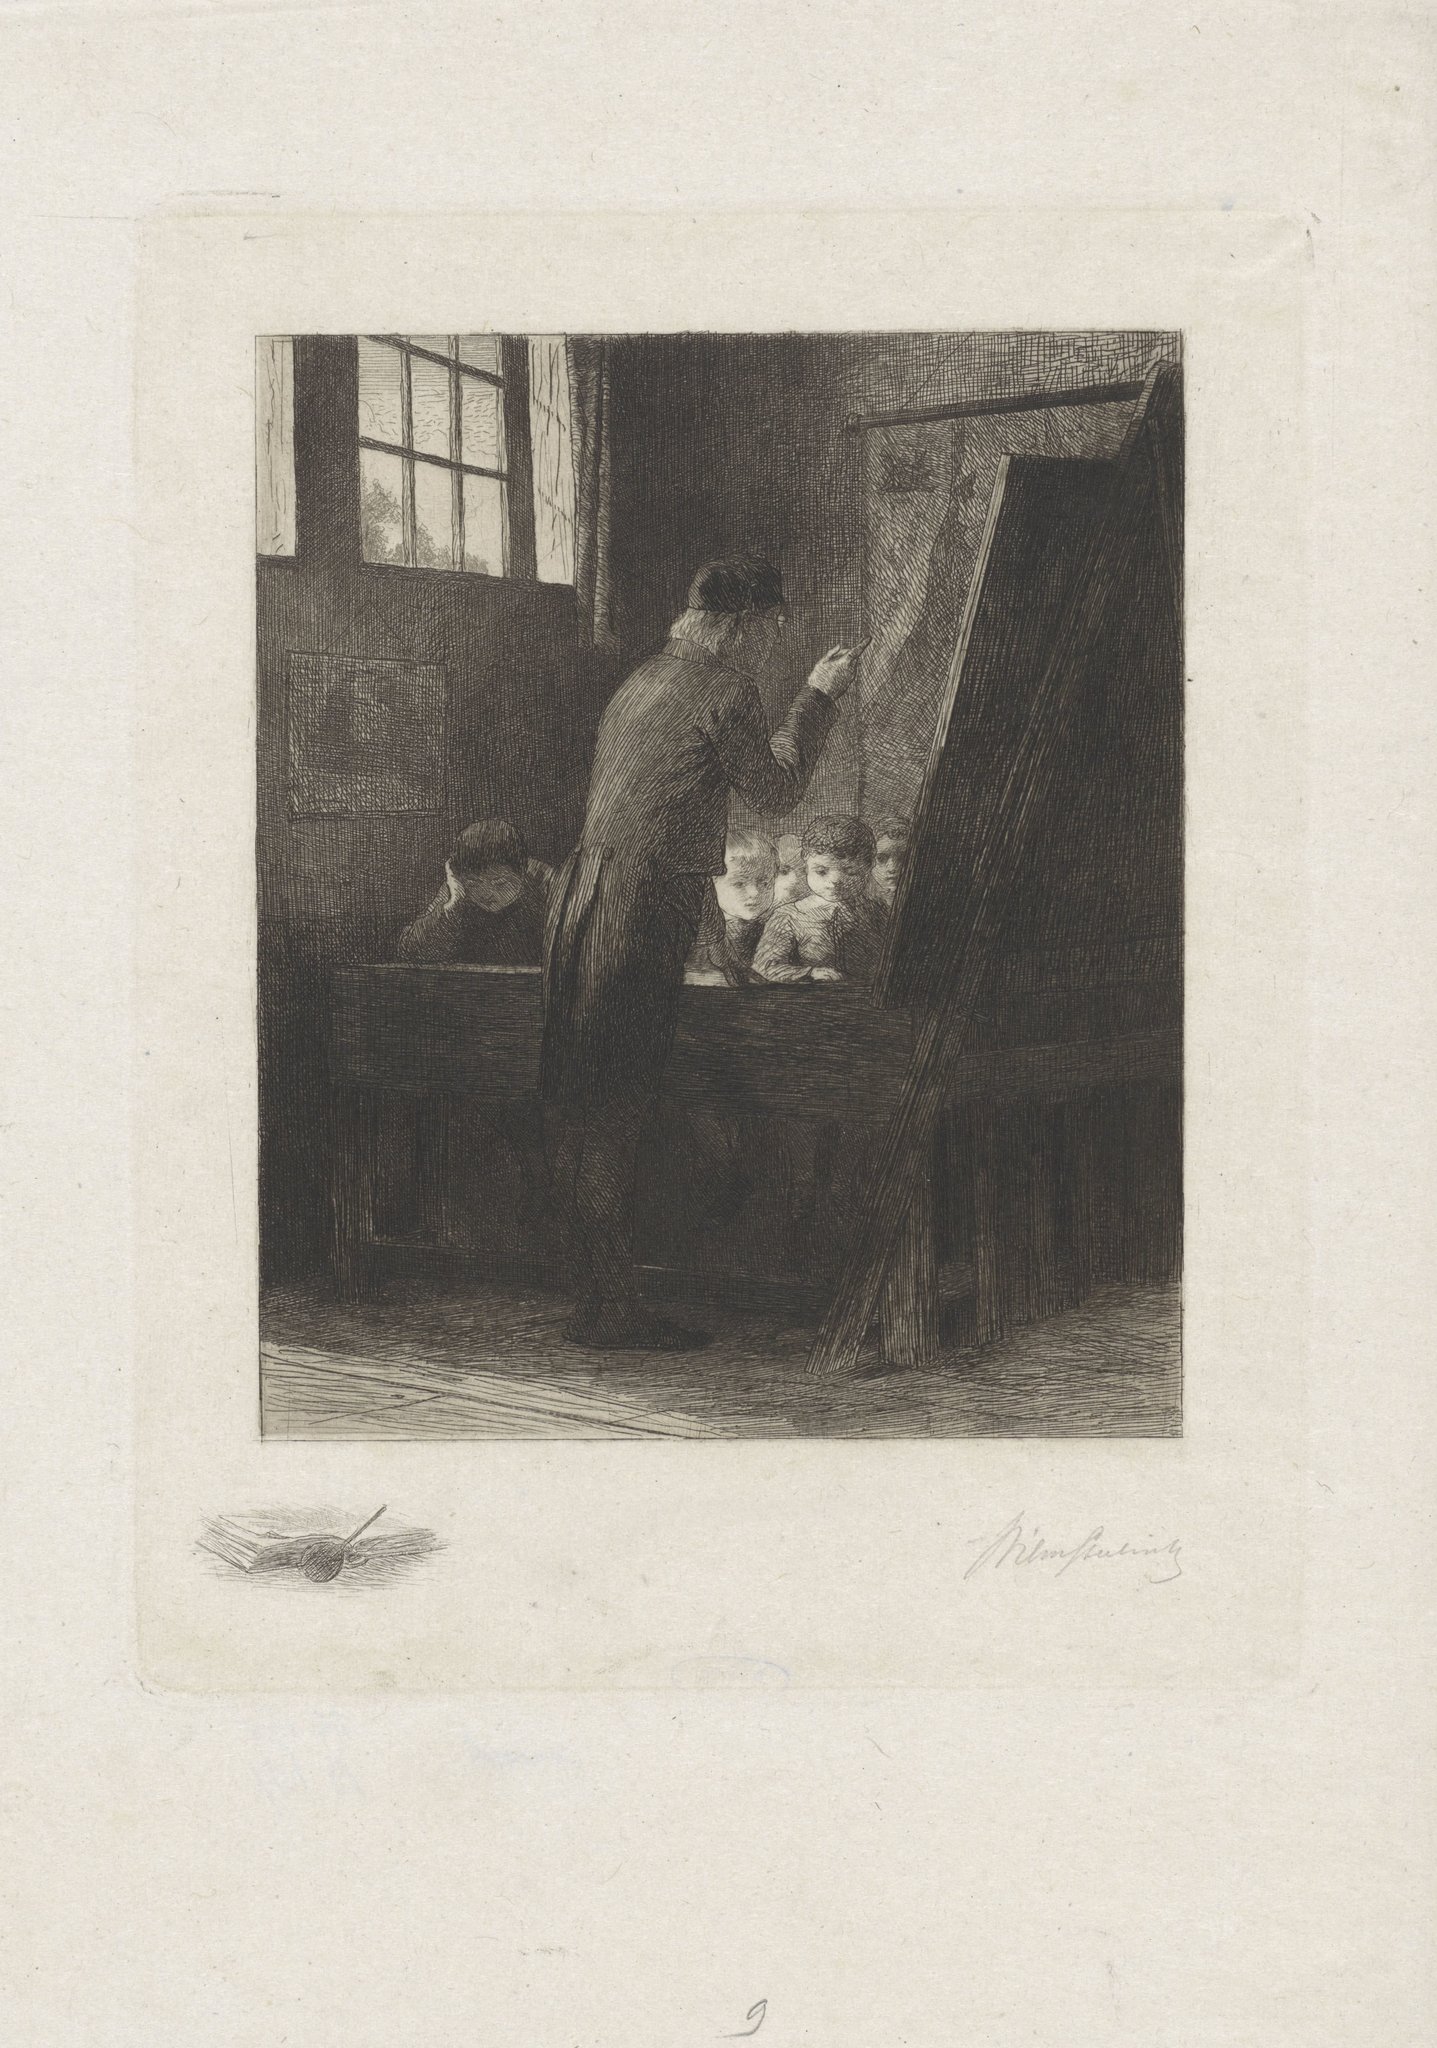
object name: print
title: Onderwijzer voor de klas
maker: willem steelink (ii)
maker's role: draughtsman, print maker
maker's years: 1856-1928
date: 1866-1886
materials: paper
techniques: etching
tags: teacher and pupil, elementary school; class, form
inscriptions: collector's mark: Lugt 2228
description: Voor een klas wijst een onderwijzer op het schoolbord. De kinderen zitten in schoolbanken. Linksonder in de marge een boek en een plak.